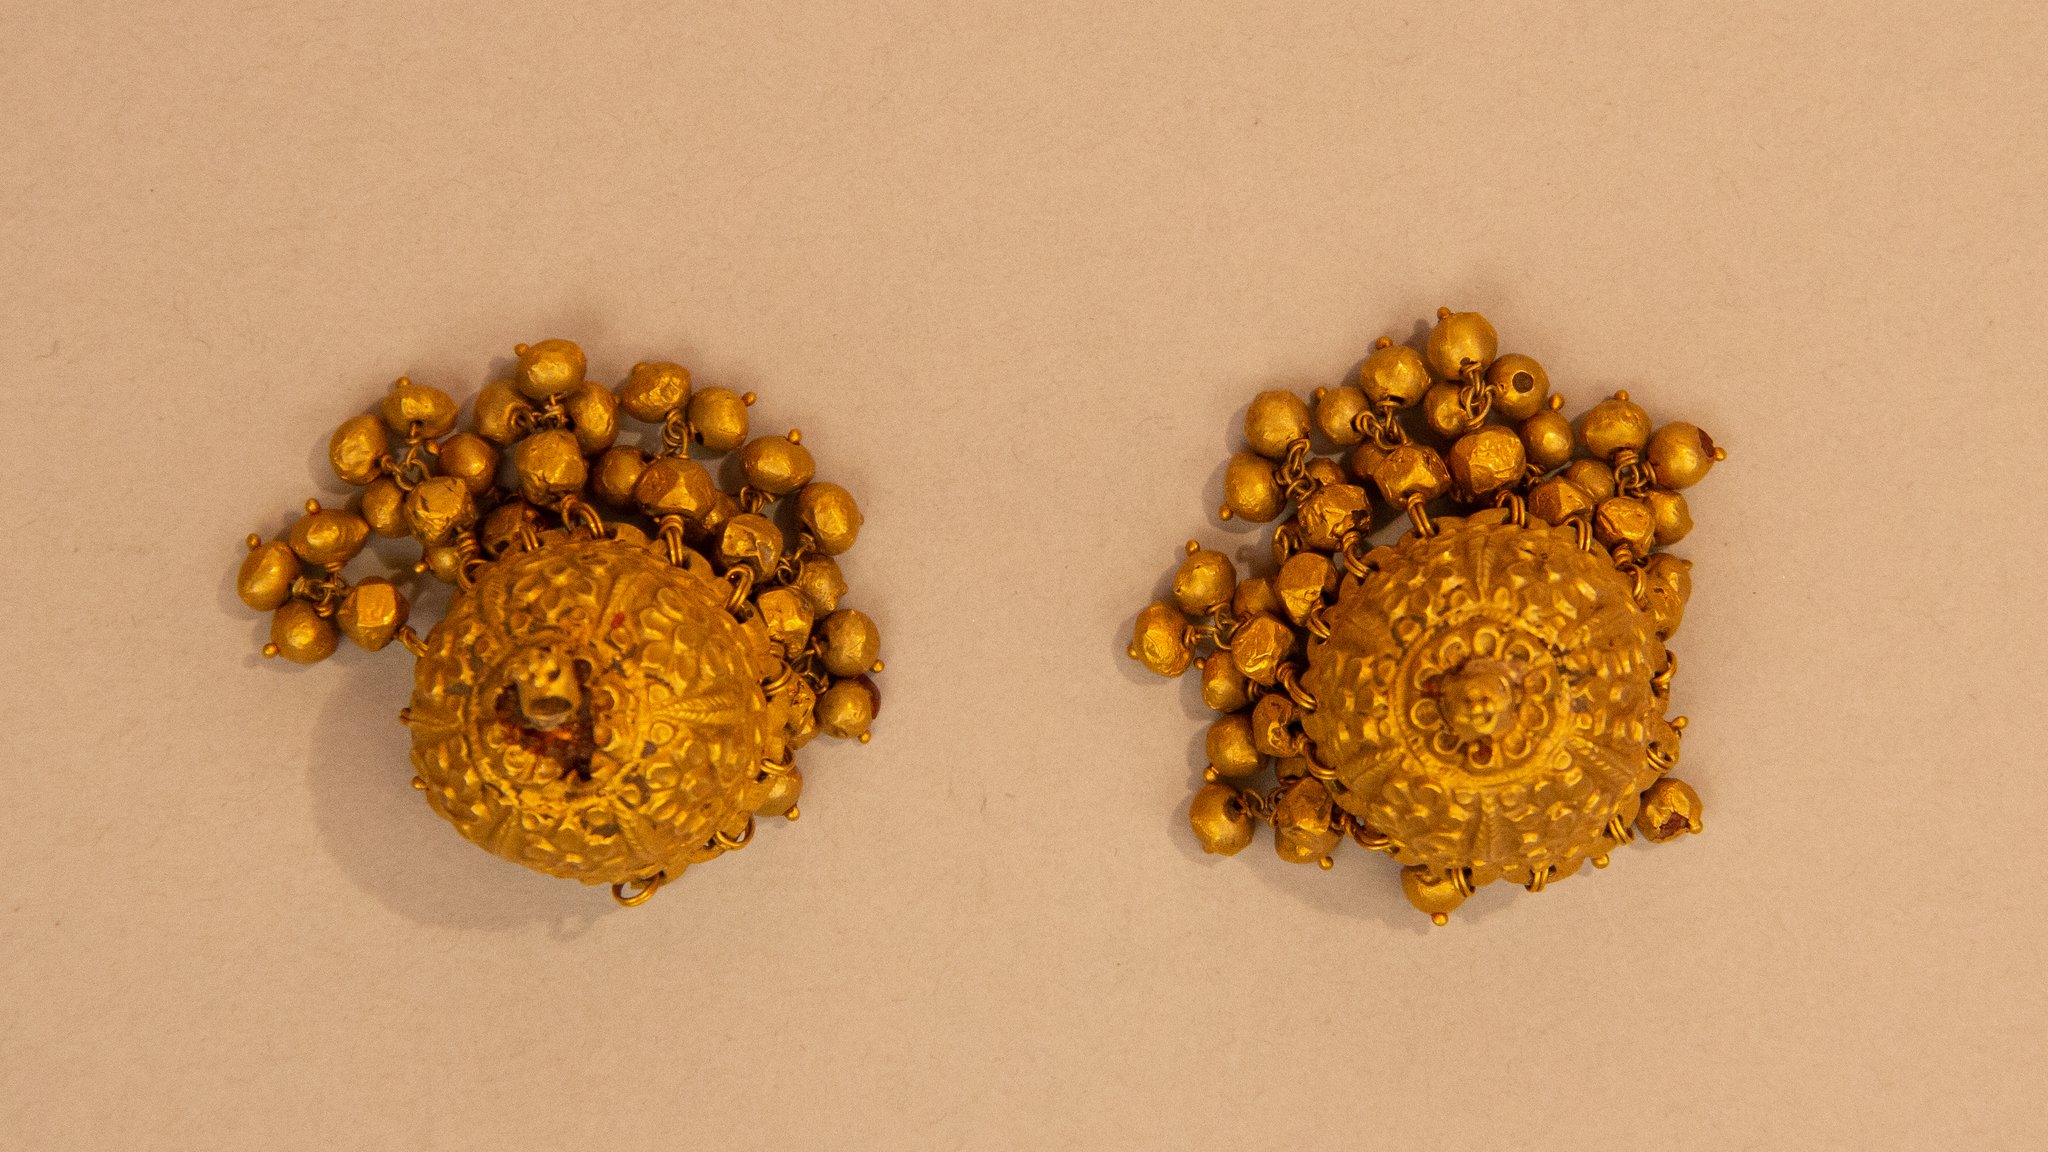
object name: pendant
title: Pendant (Jkumka), One of a Pair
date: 1701-1900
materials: gold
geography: northern india